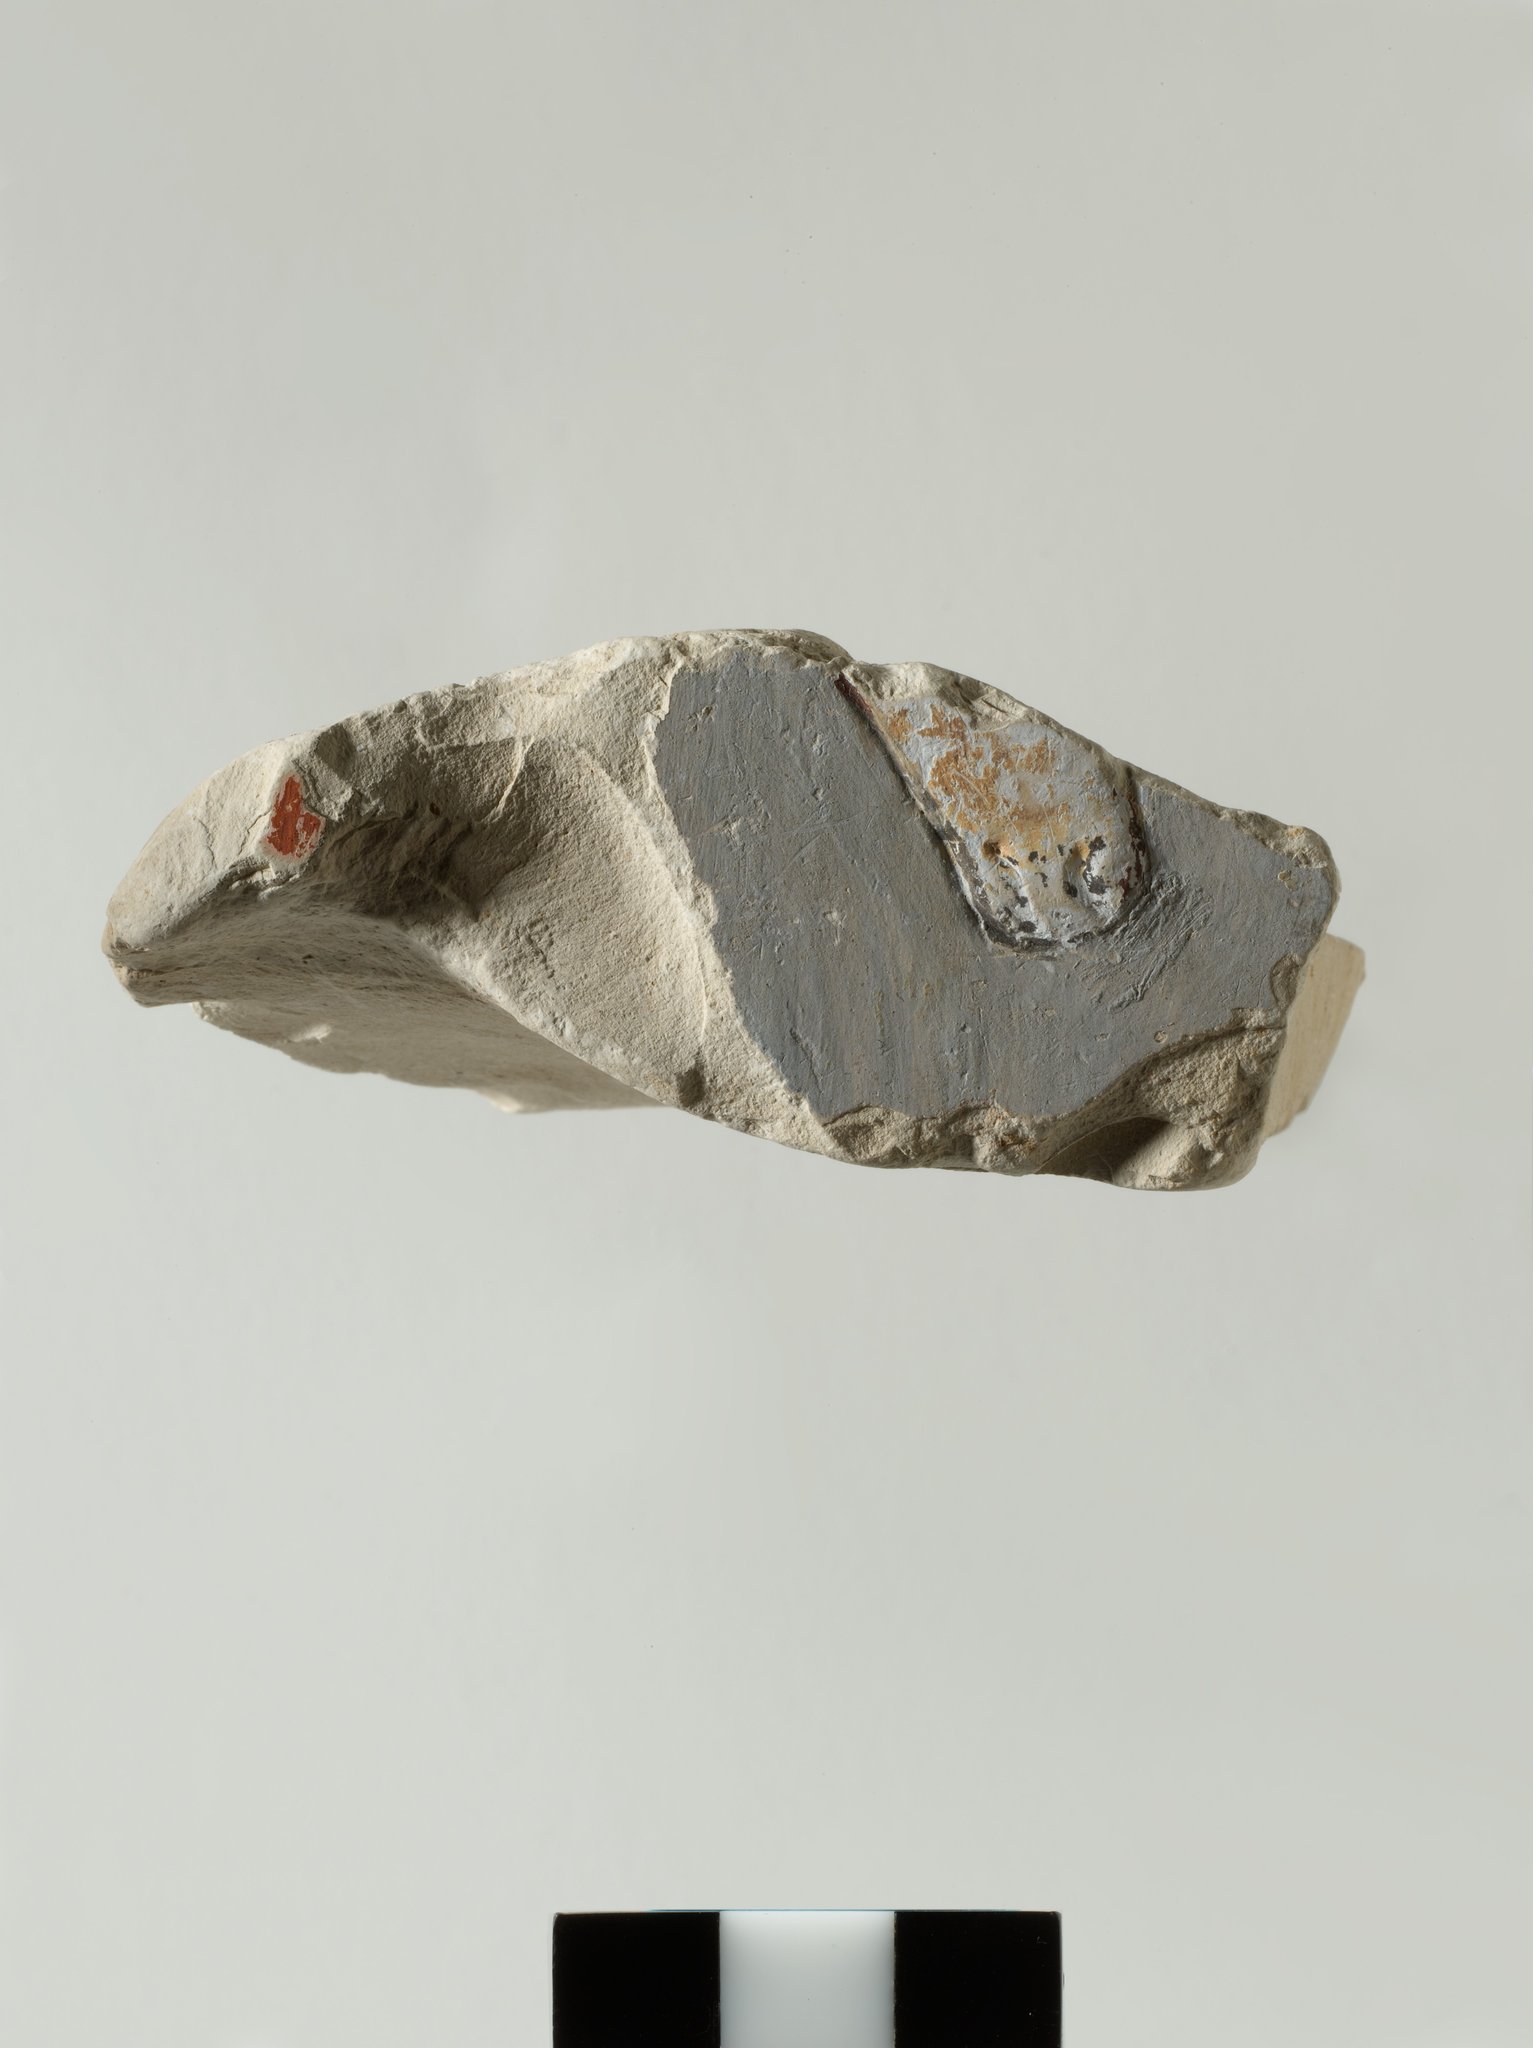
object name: relief fragment, tomb of meketre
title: Relief fragment from the tomb of Meketre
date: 1981-1975 BCE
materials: limestone, paint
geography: egypt